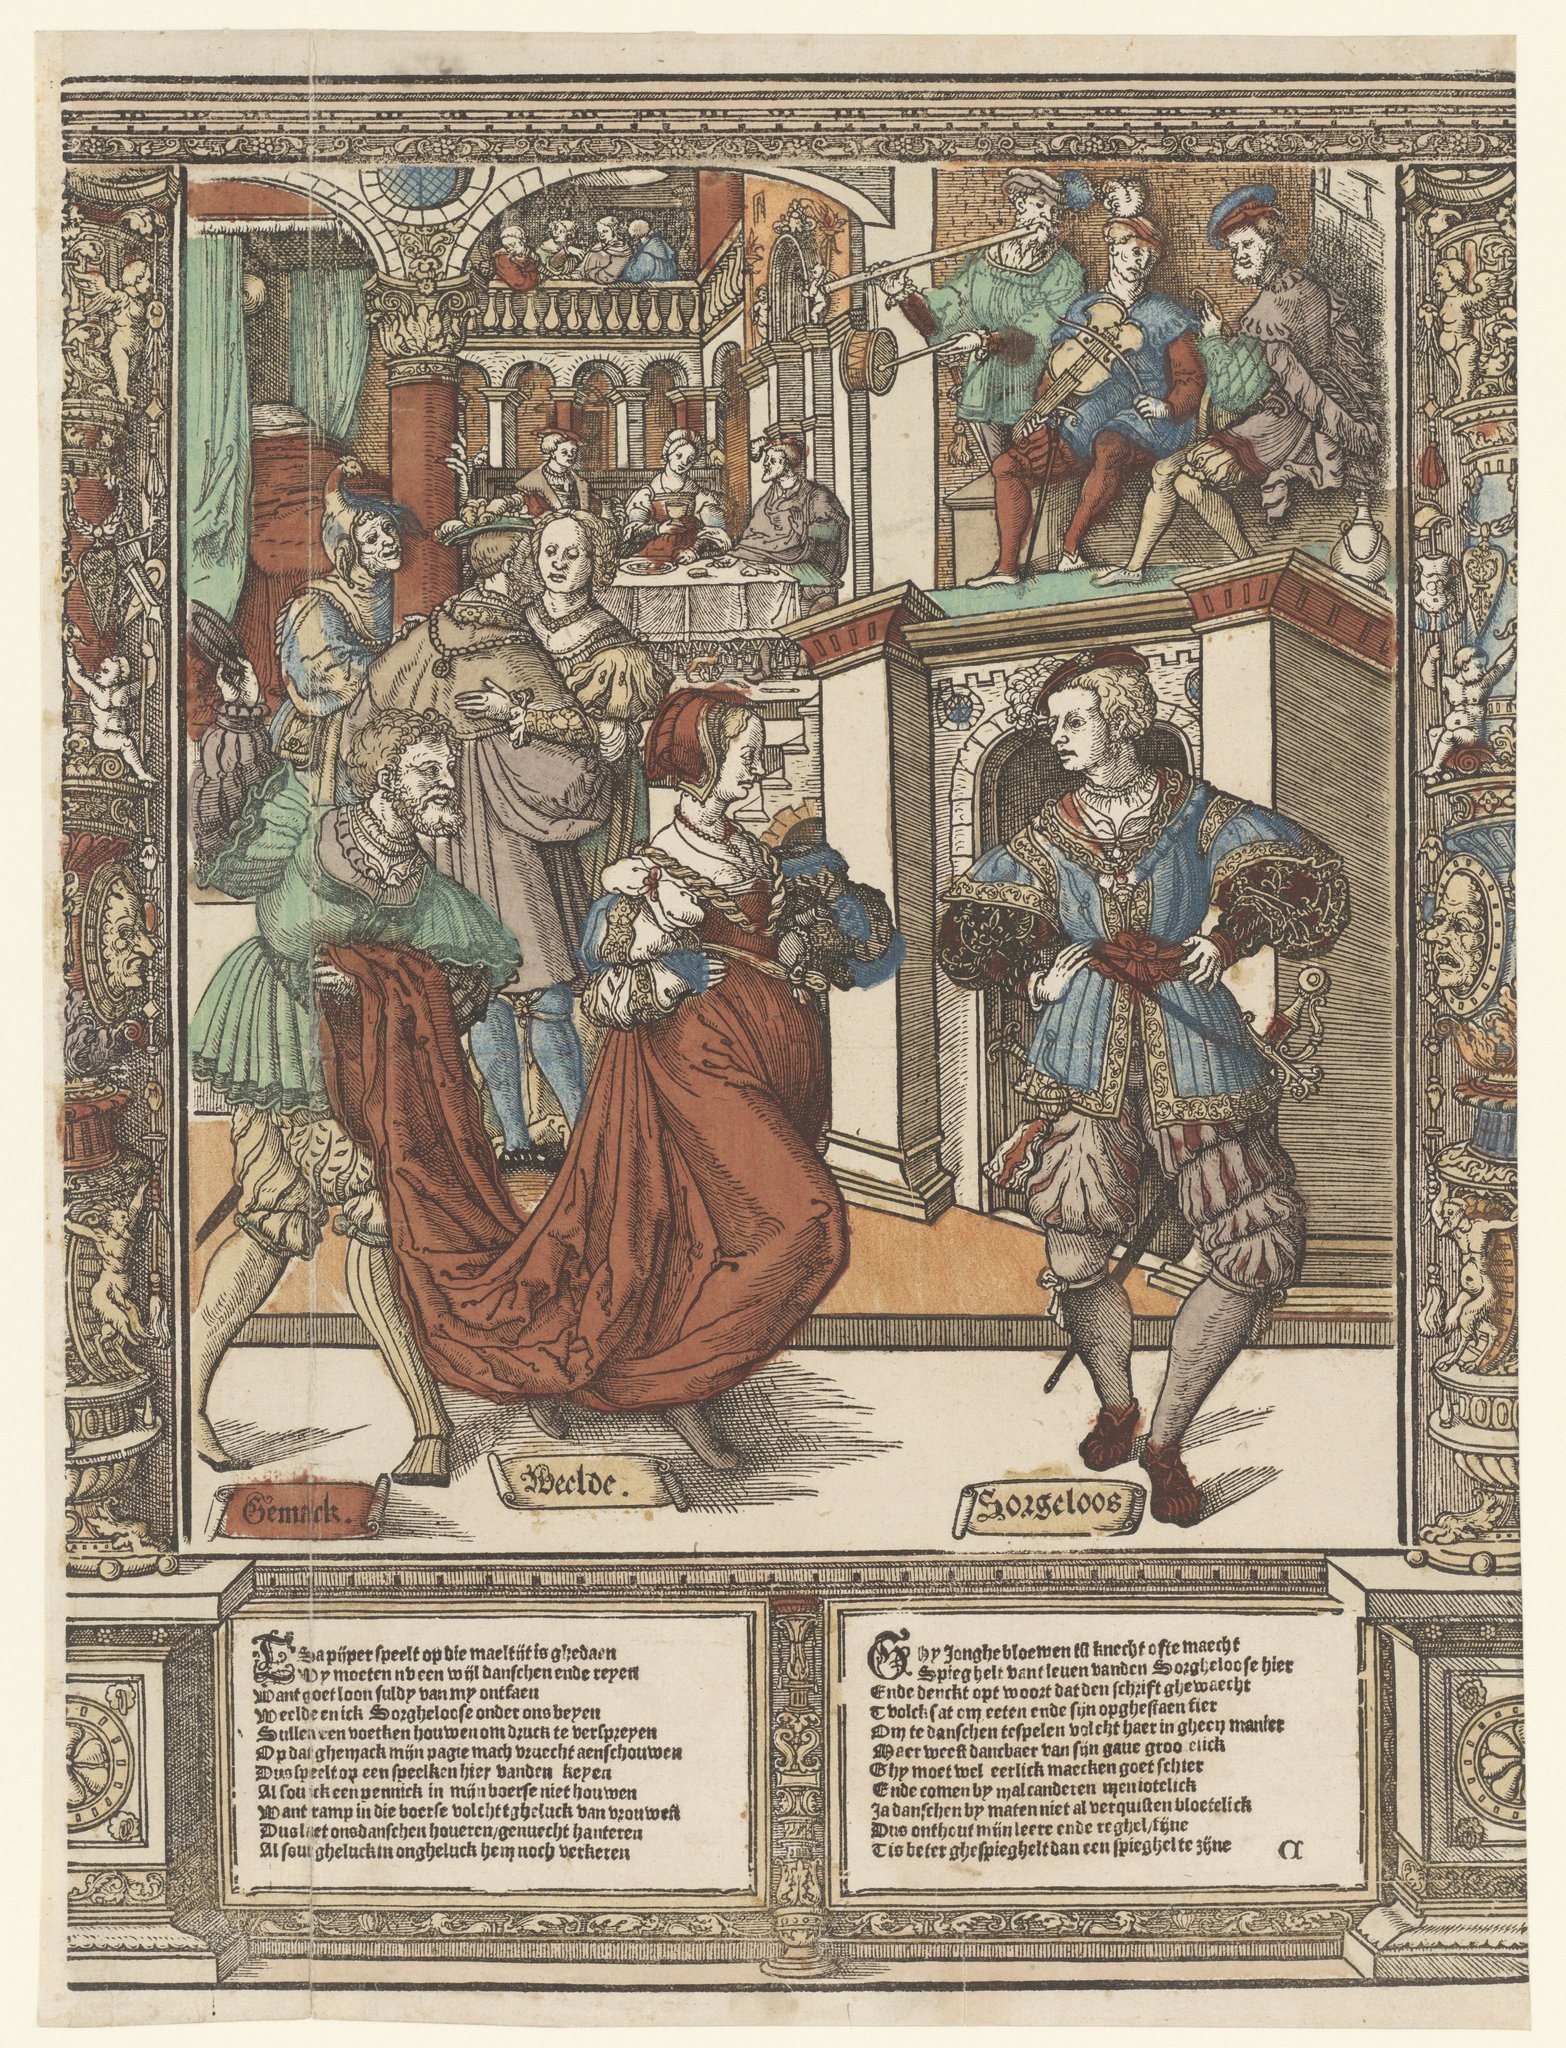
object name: print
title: Het verhaal van Sorgheloos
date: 1541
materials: paper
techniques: hand coloring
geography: amsterdam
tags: small group of musicians, chamber orchestra, jazz band, ball, formal dance, carelessness, wealth, opulence; 'opulenza', 'richezza' (ripa), sluggishness, inertia; 'dapocaggine', 'pigritia' (ripa), more than one couple dancing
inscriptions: number: ‘257 L(?)i’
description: Sorgheloos dansend met Weelde. Rechts op een verhoging zittende muzikanten. Ornamentele omlijsting rond voorstelling met het bal. Binnen omlijsting twee elfregelige gedichten in het Nederlands. Prent drie van serie van zes.